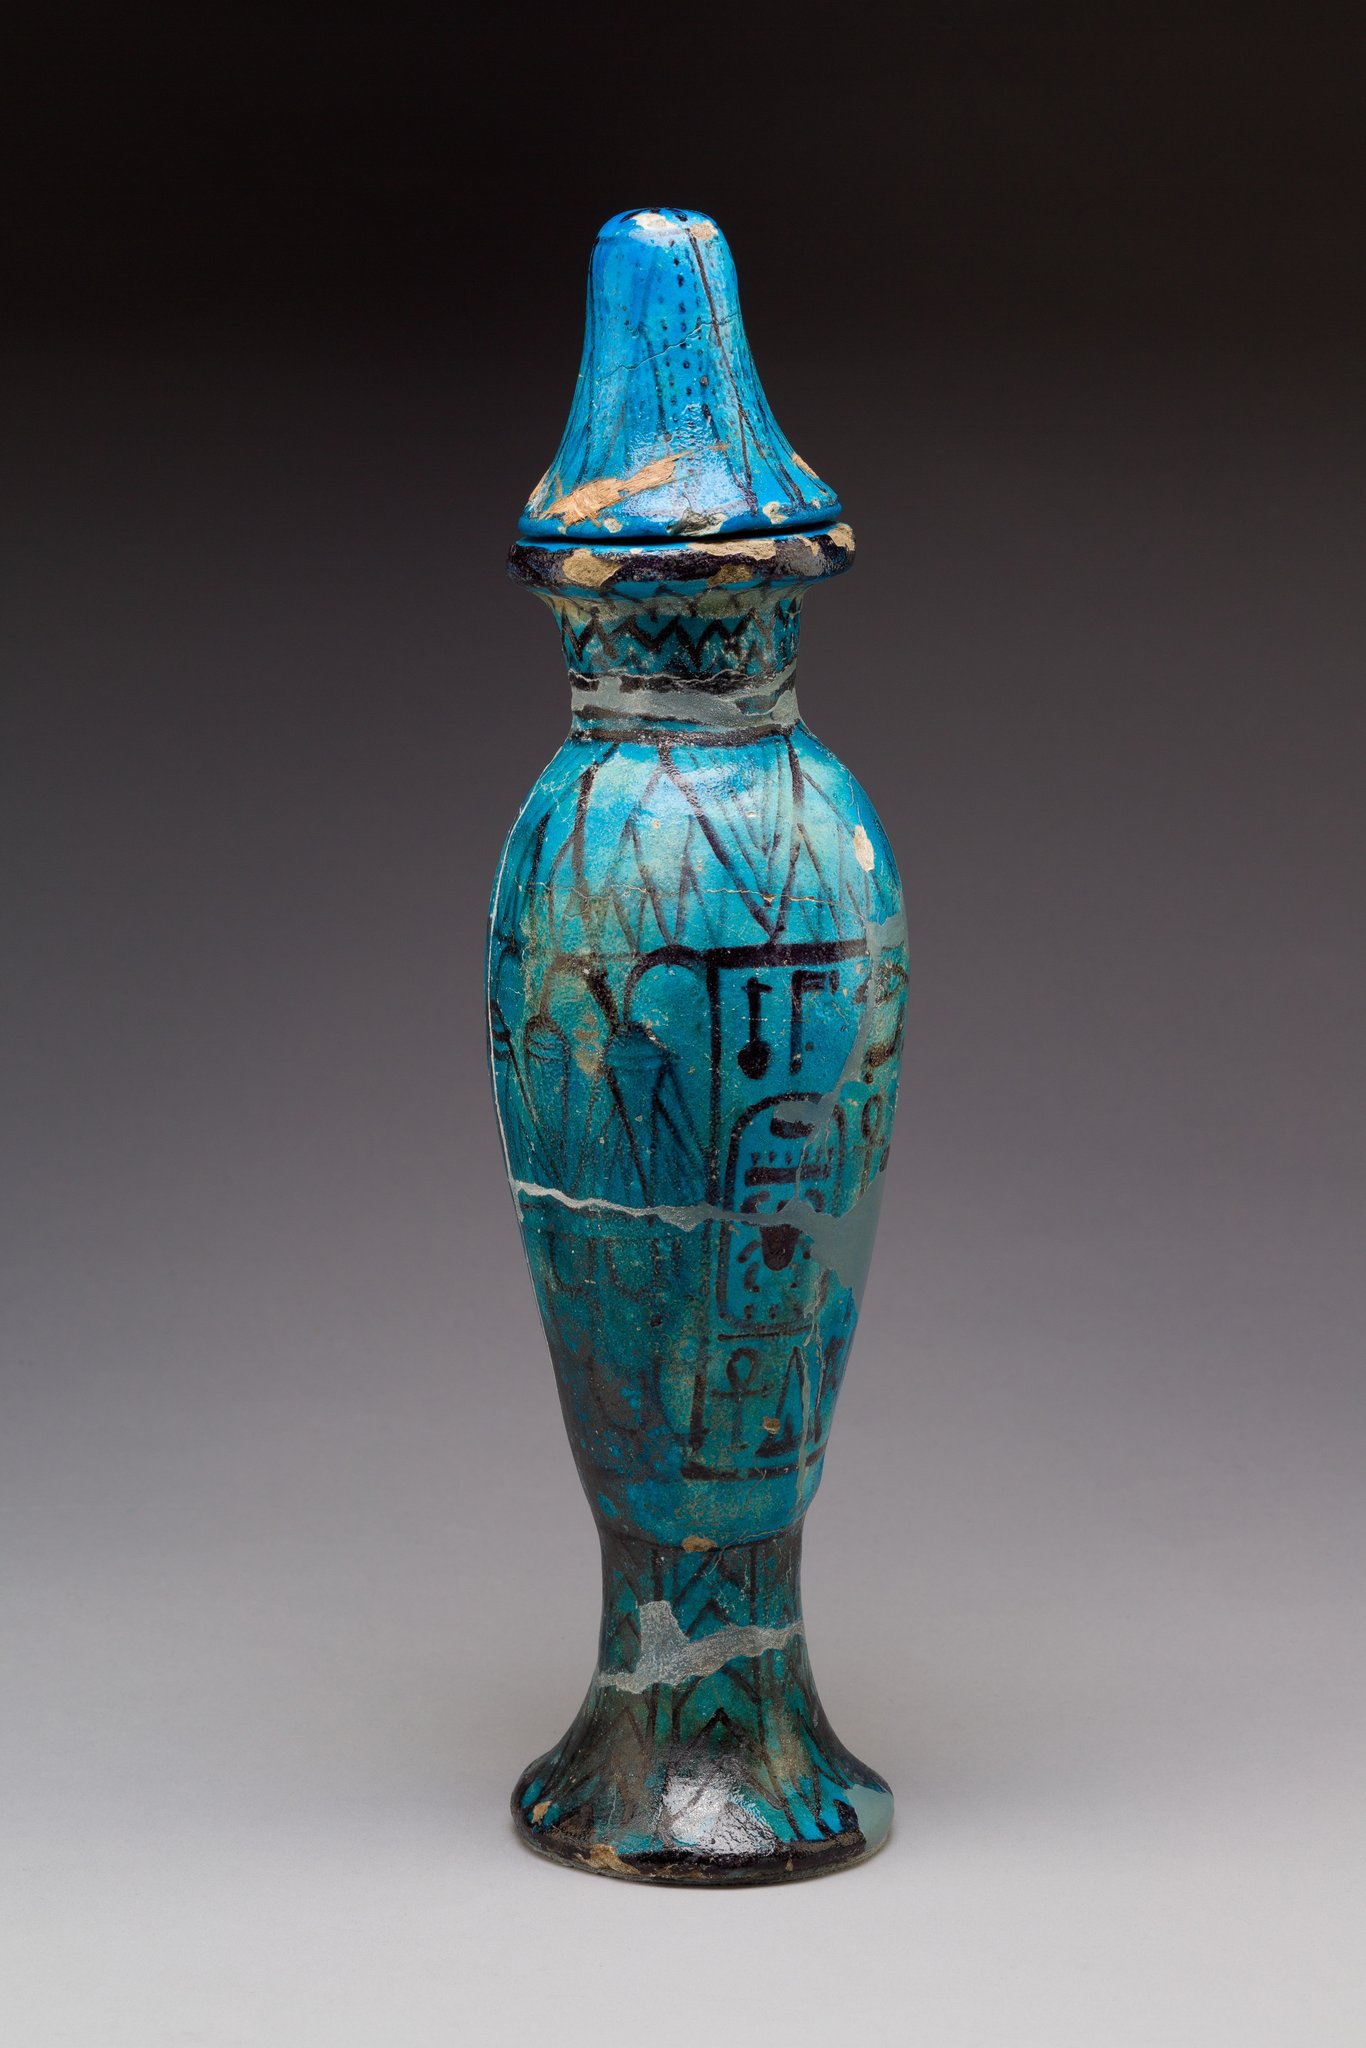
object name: libation vessel, he vase, thutmose iv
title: Hes Vase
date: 1400-1390 BCE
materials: faience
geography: egypt